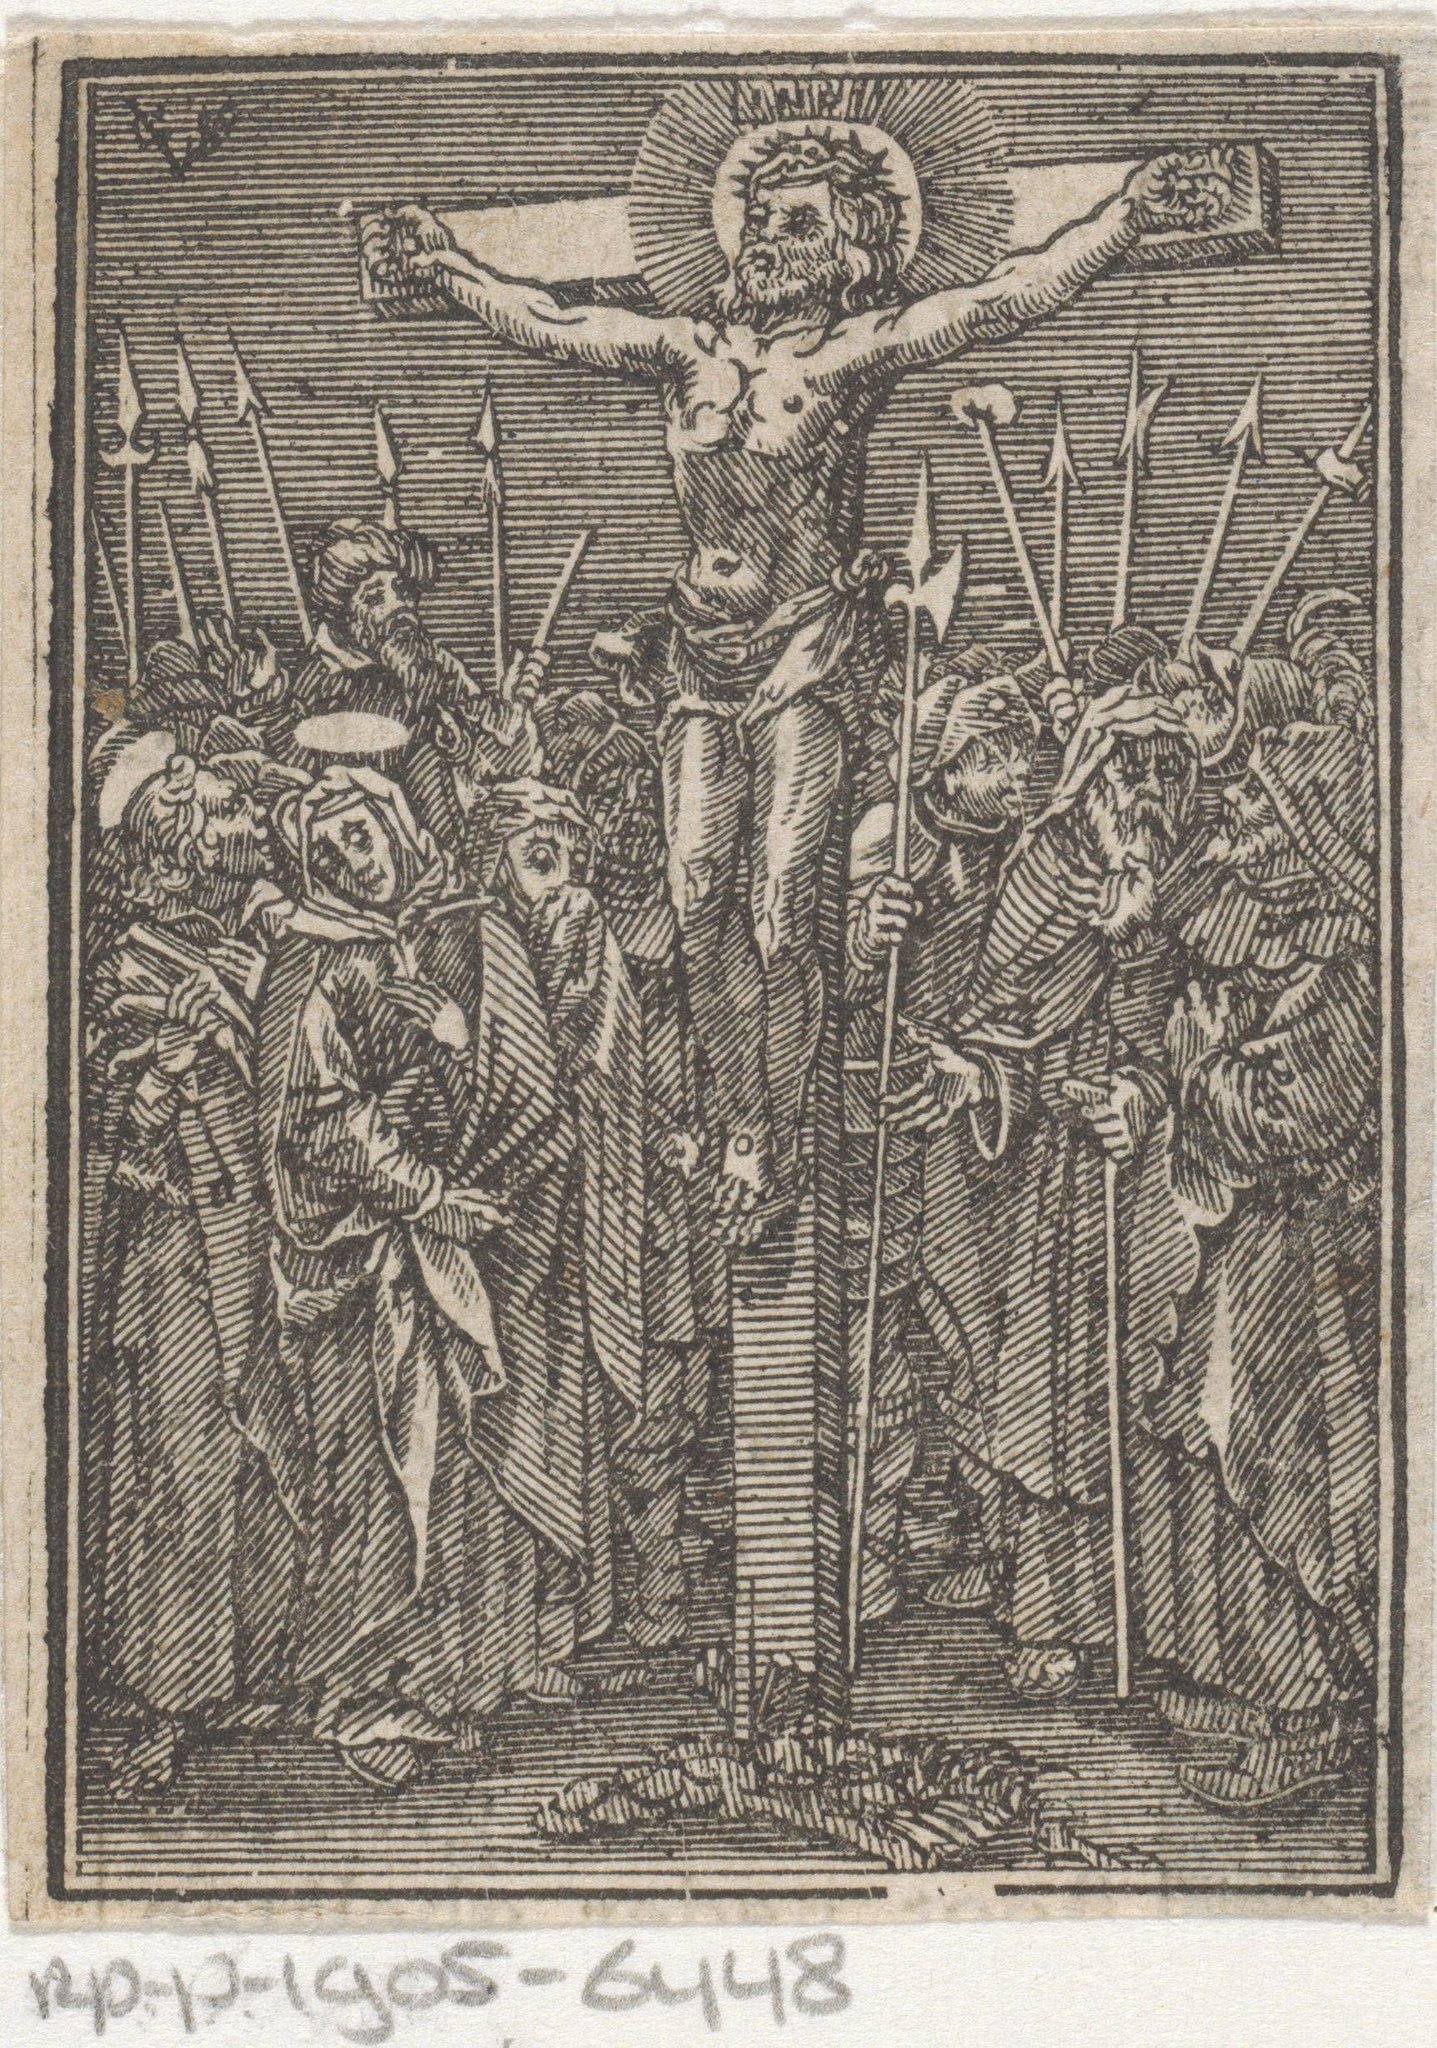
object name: book illustration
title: Christus aan het kruis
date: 1648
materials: paper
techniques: letterpress printing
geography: amsterdam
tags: crucified christ, with particular persons under the cross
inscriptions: collector's mark: Lugt 2228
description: Prent uit: Sichem, Christoffel van (II). 'tSchat der zielen, dat is: Het geheele leven ons Heeren Iesu Christi. Amsterdam: Pieter Jacobsz. Paets, 1648. Prent uit: Biblia sacra dat is De geheele Heylighe Schrifture bedeylt in 't Out en Nieu Testament. Amsterdam: Pieter Jacobsz. Paets, 1657.